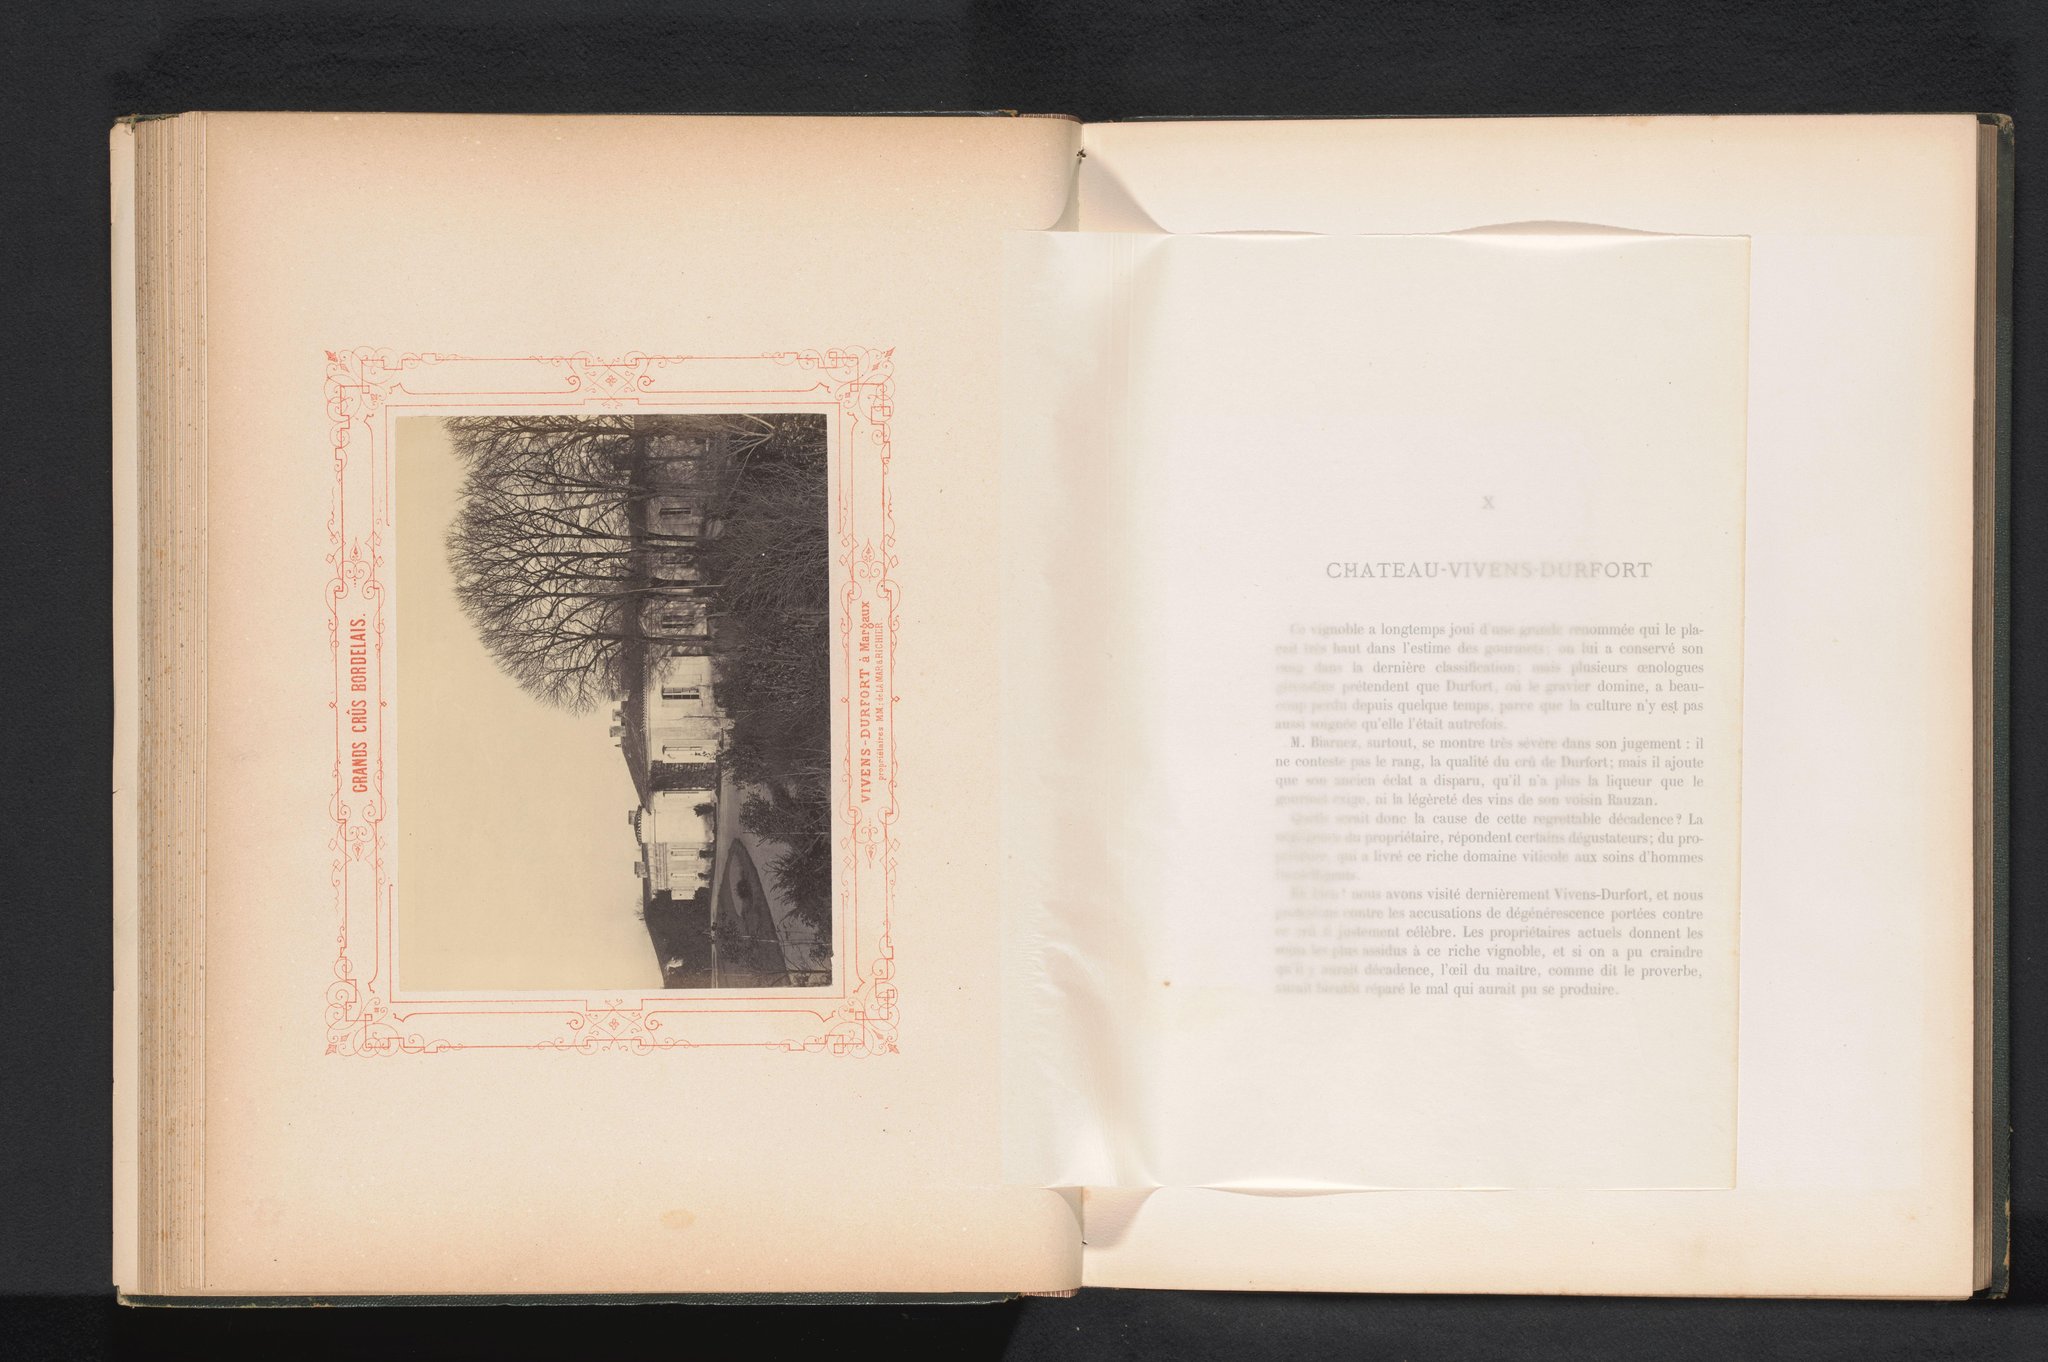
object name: page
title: Gezicht op Château Durfort-Vivens in Margaux, Frankrijk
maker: alfred danflou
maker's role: fotograaf, schrijver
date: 1862-1867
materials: photographic support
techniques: albumen print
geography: margaux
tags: castle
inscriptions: inscription: ‘propriétaires M.M: de LA MAR & RICHIER.’